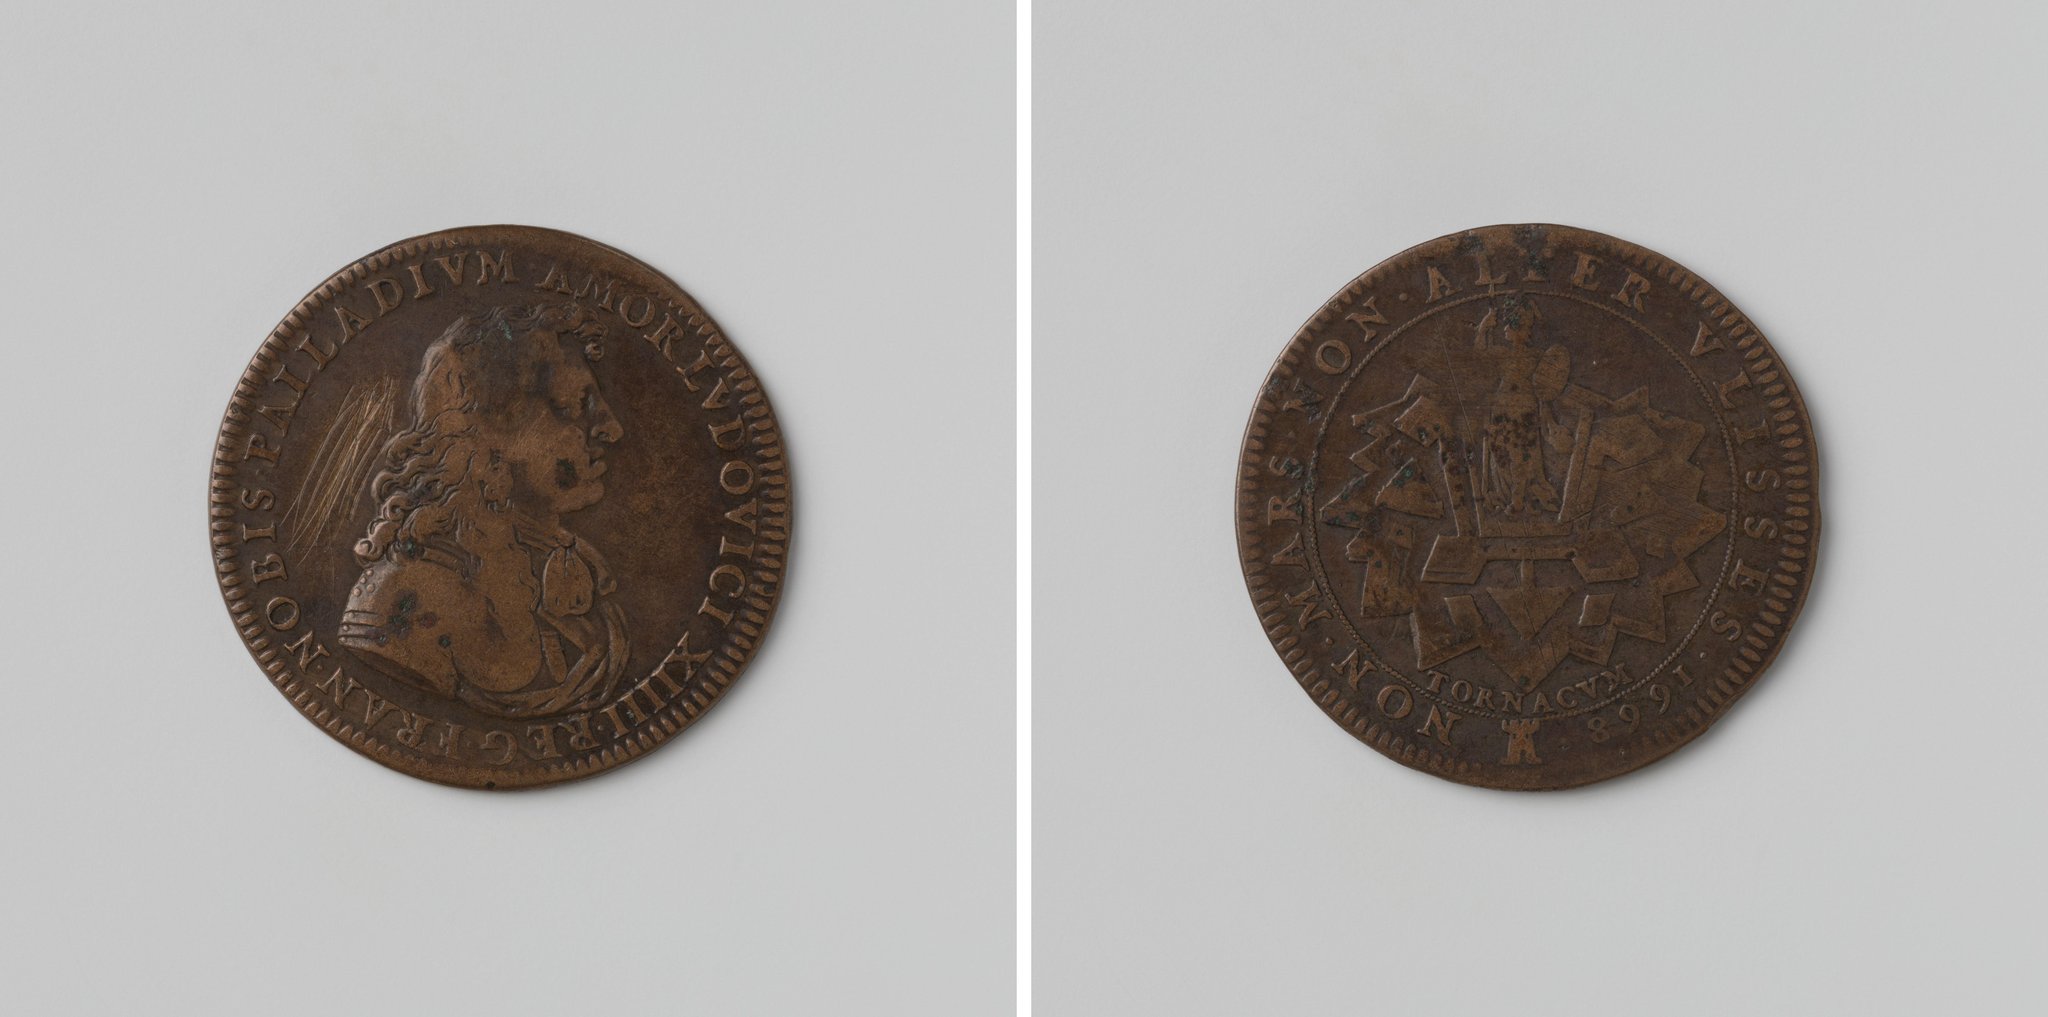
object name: jeton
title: Versterking van de stad Doornik, rekenpenning geslagen ter ere van Lodewijk XIV, koning van Frankrijk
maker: Anonymous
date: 1668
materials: copper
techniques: striking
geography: france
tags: lodewijk xiv (koning van frankrijk)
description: Koperen penning. Voorzijde: borststuk man binnen omschrift. Keerzijde: plattegrond van fortificaties van Doornik; in citadel: gehelmde Minerva met speer en schild boven opschrift binnen omschrift